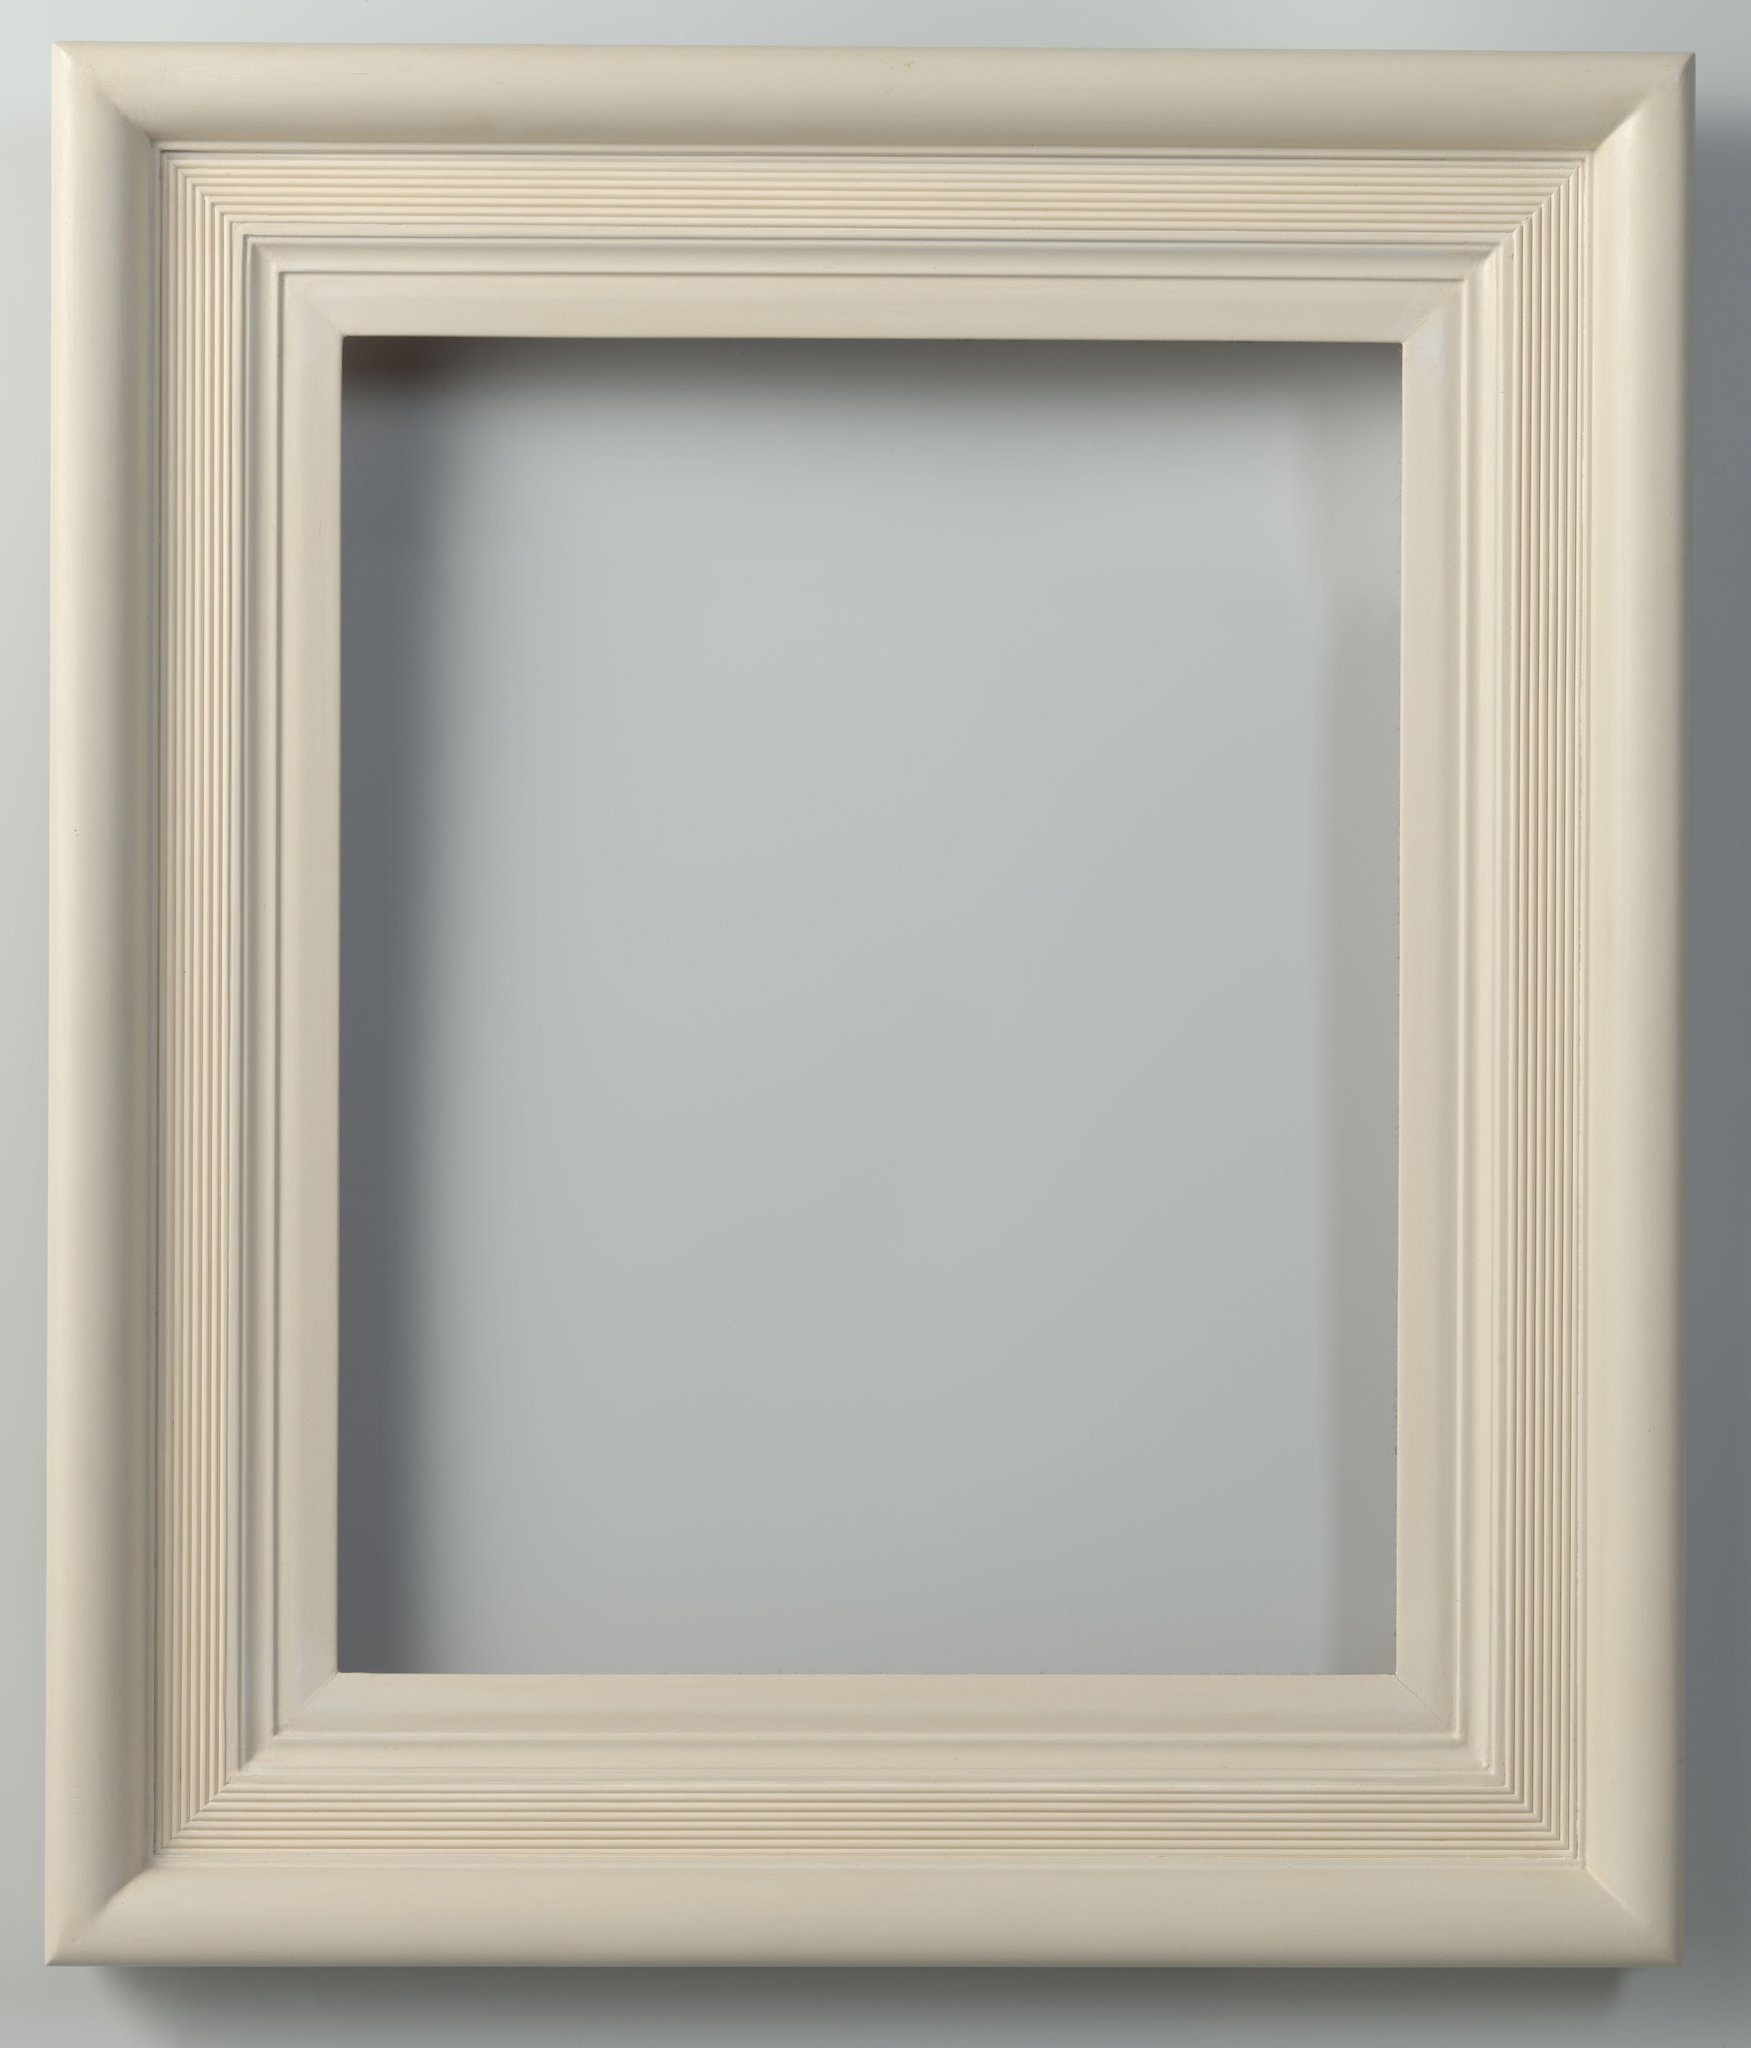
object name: frame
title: Lijst voor Zelfportret in het atelier van Anton Molkenboer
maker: Anonymous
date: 1896-1920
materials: wood